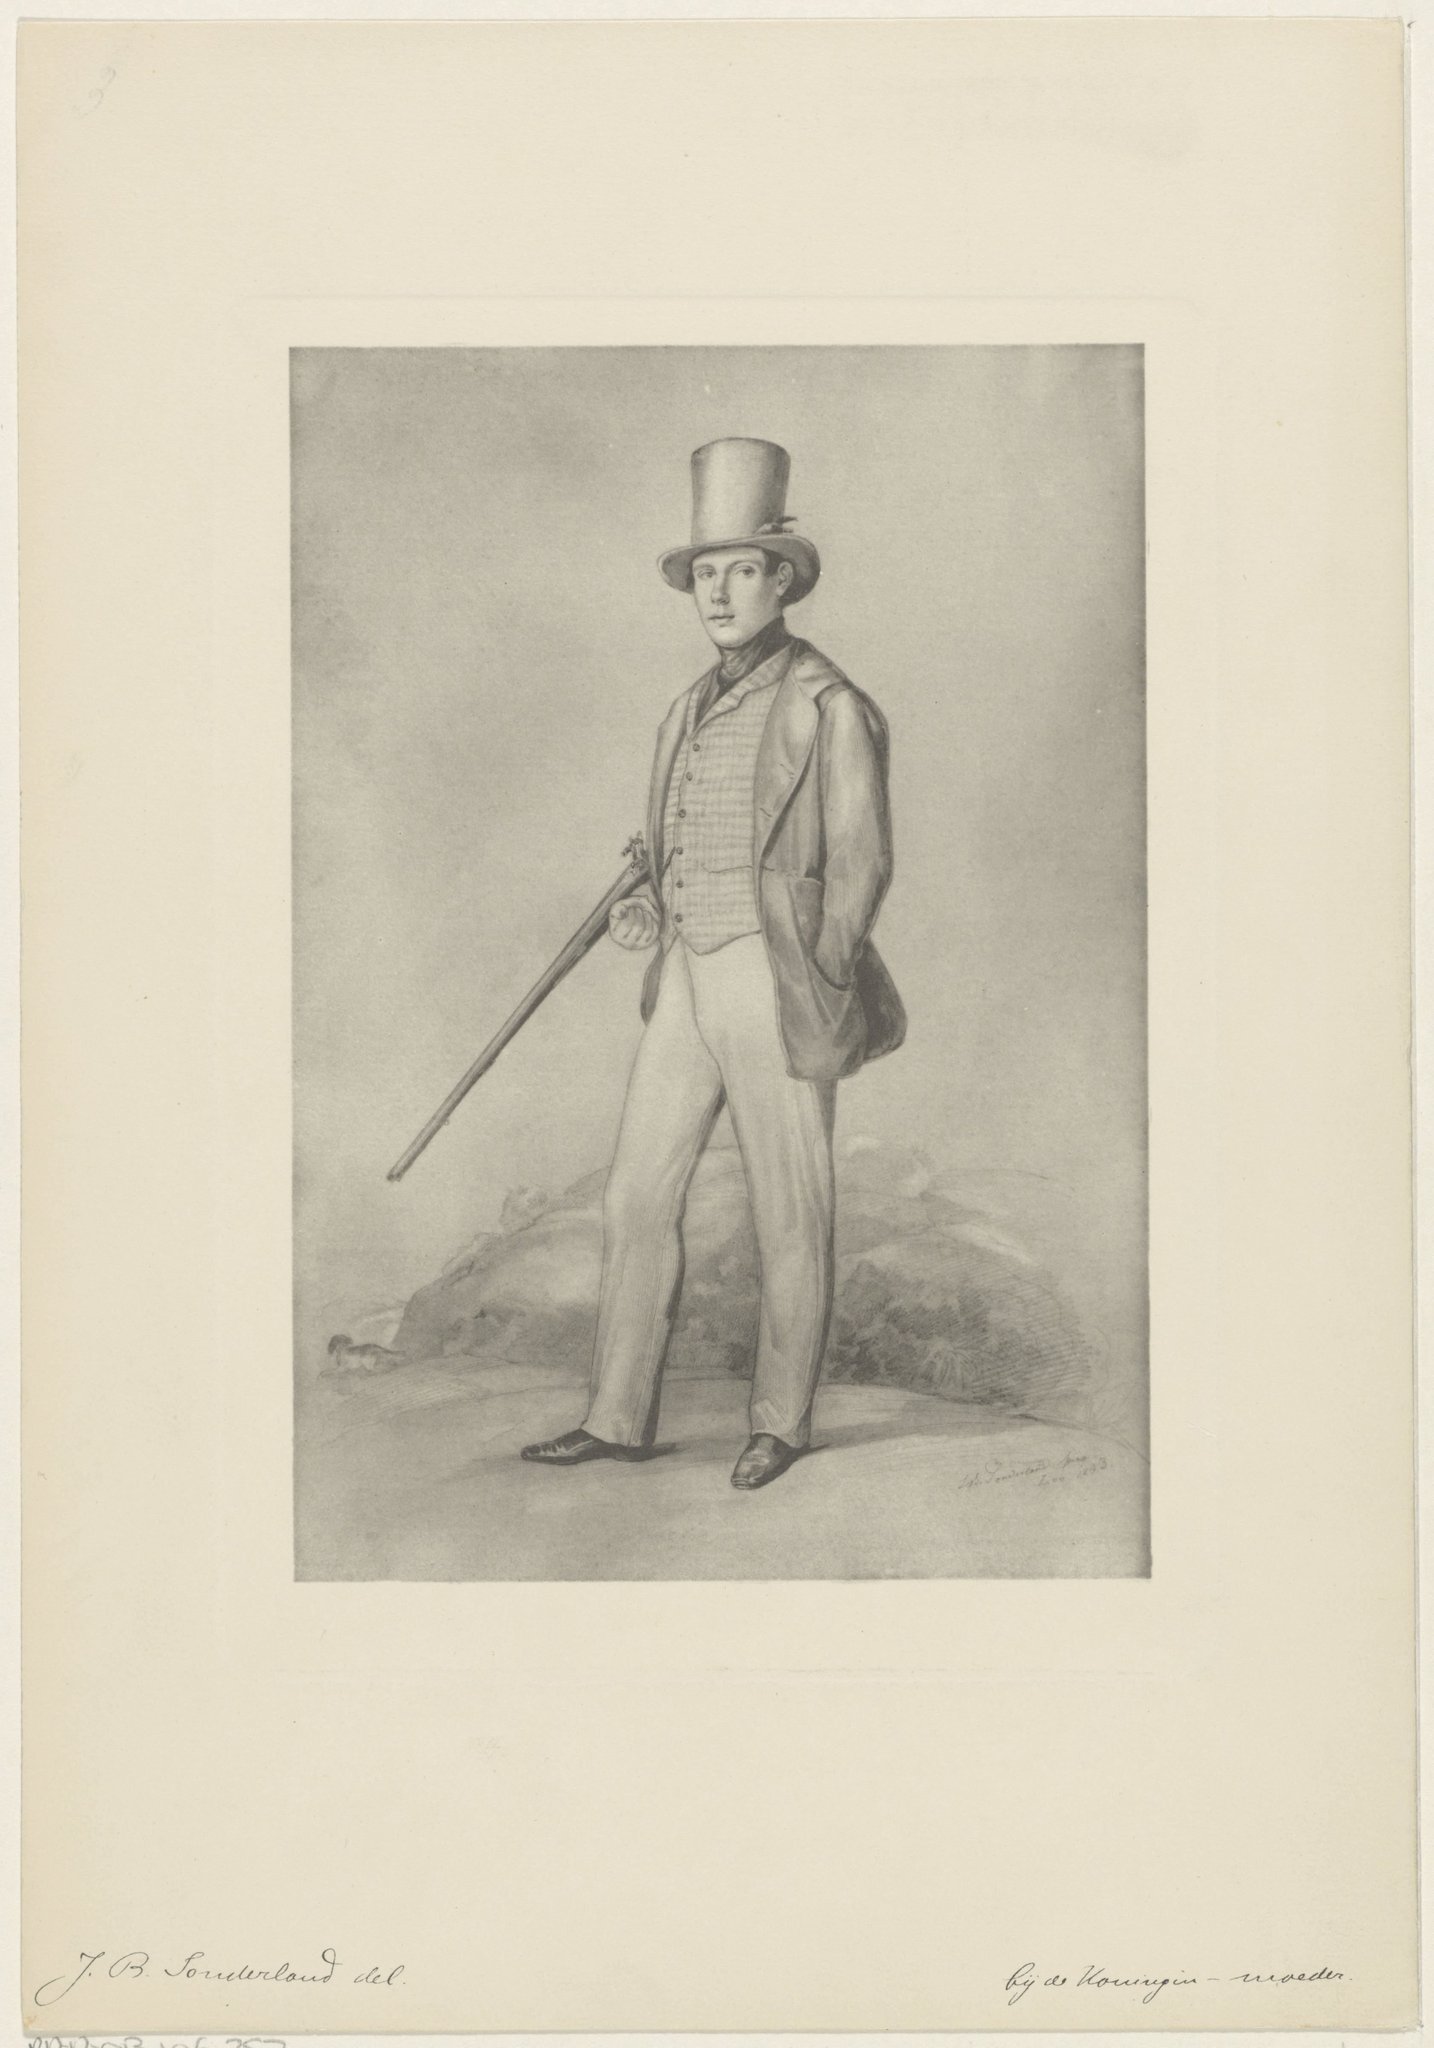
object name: photomechanical print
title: Portret van Alexander I, prins der Nederlanden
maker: Anonymous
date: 1850-1949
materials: paper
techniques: photograph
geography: netherlands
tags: alexander (prins der nederlanden, prins van oranje-nassau)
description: De hier vermelde titel verwijst naar de hoogst verkregen titel van de geportretteerde, niet per se naar de titel die de geportretteerde op deze voorstelling draagt.